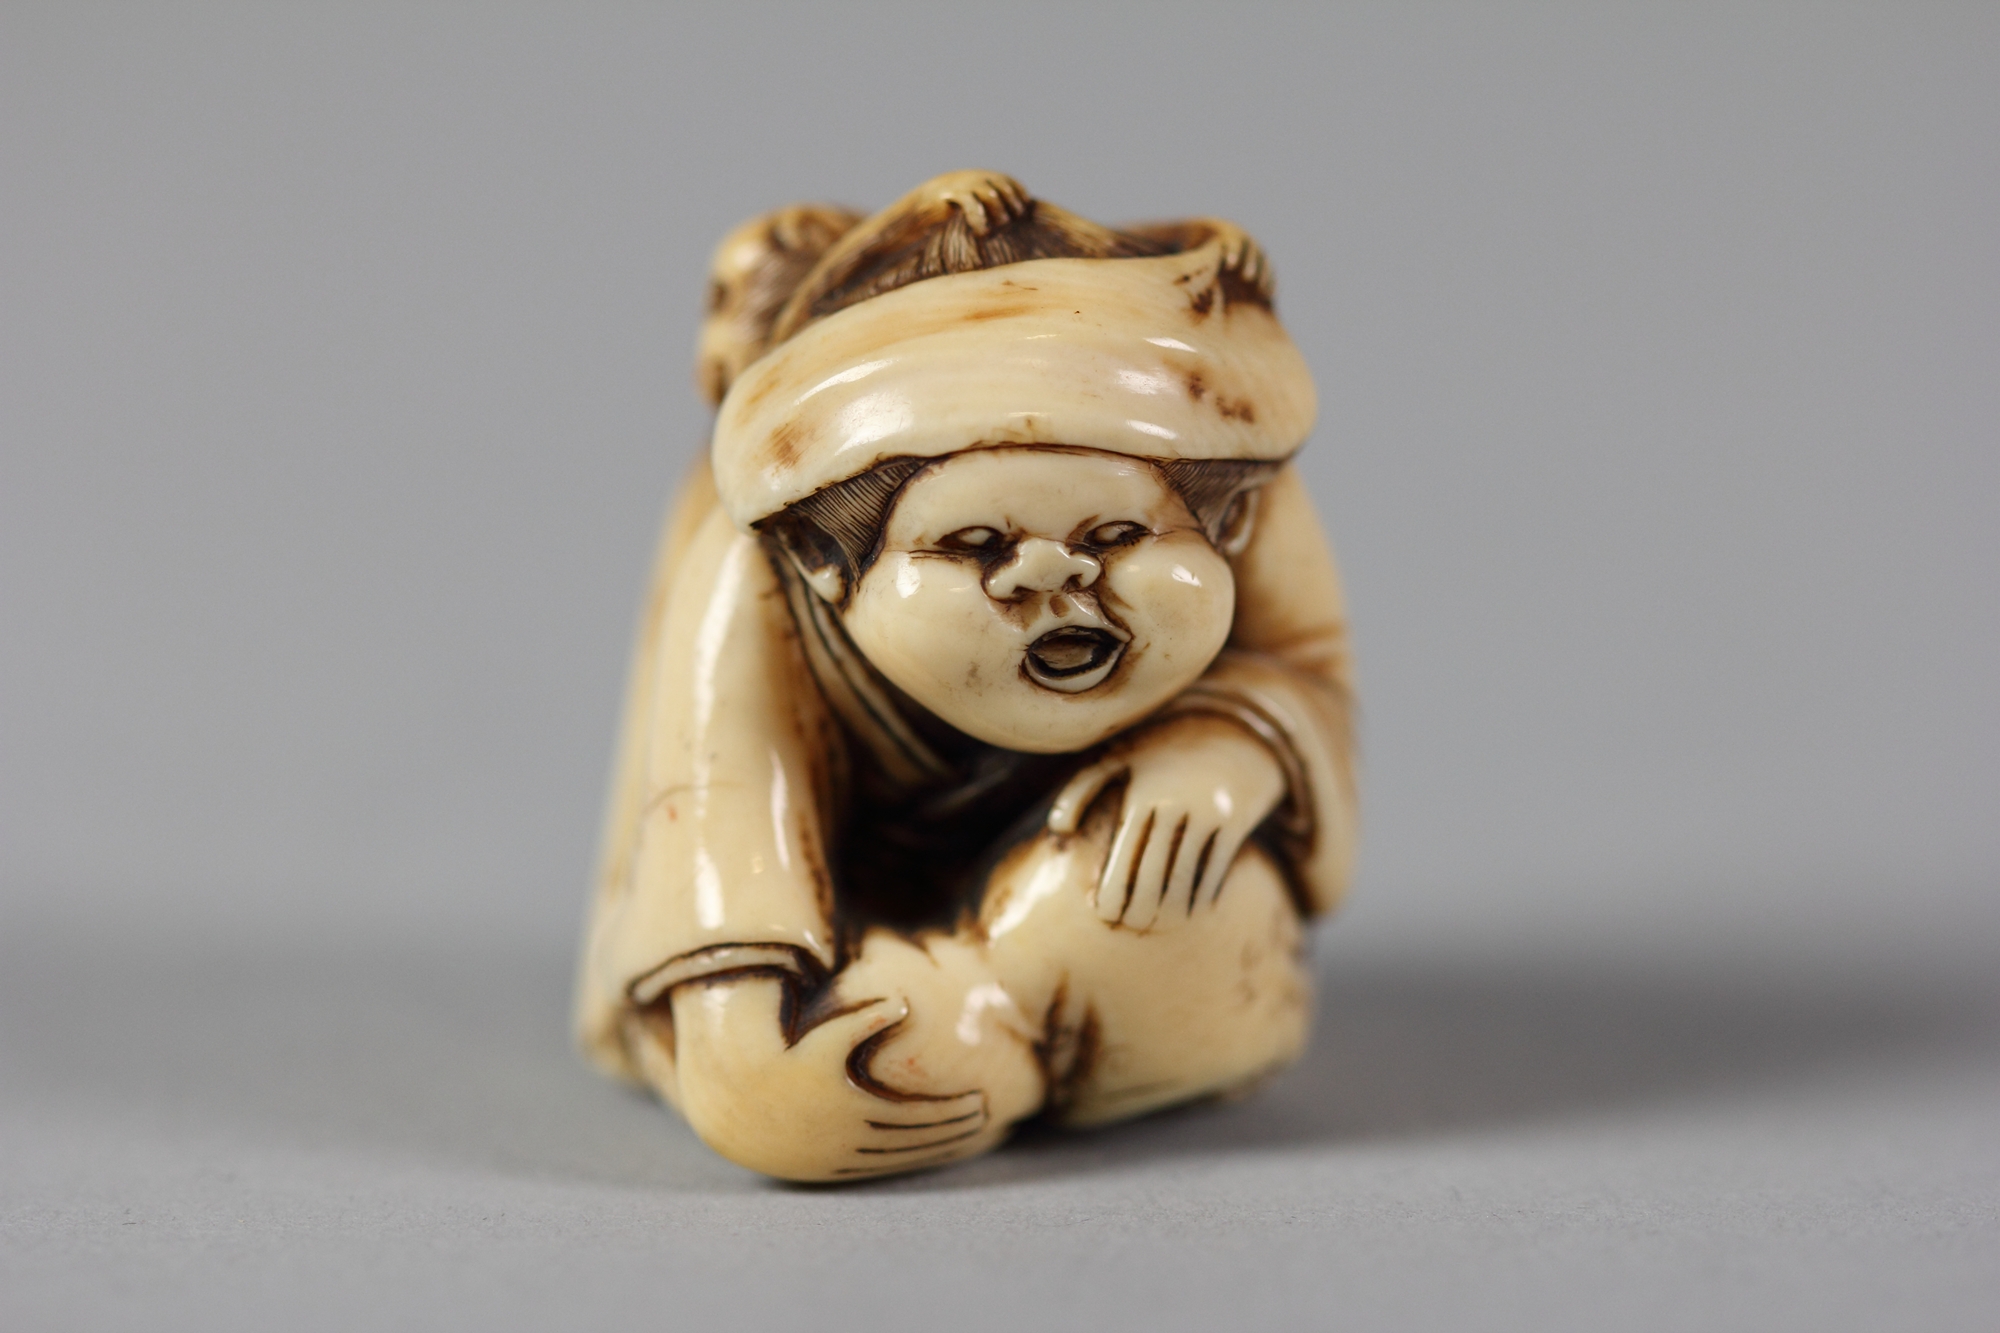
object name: netsuke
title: Netsuke of Woman and Monkey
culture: japanese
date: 1801-1900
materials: ivory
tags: monkeys